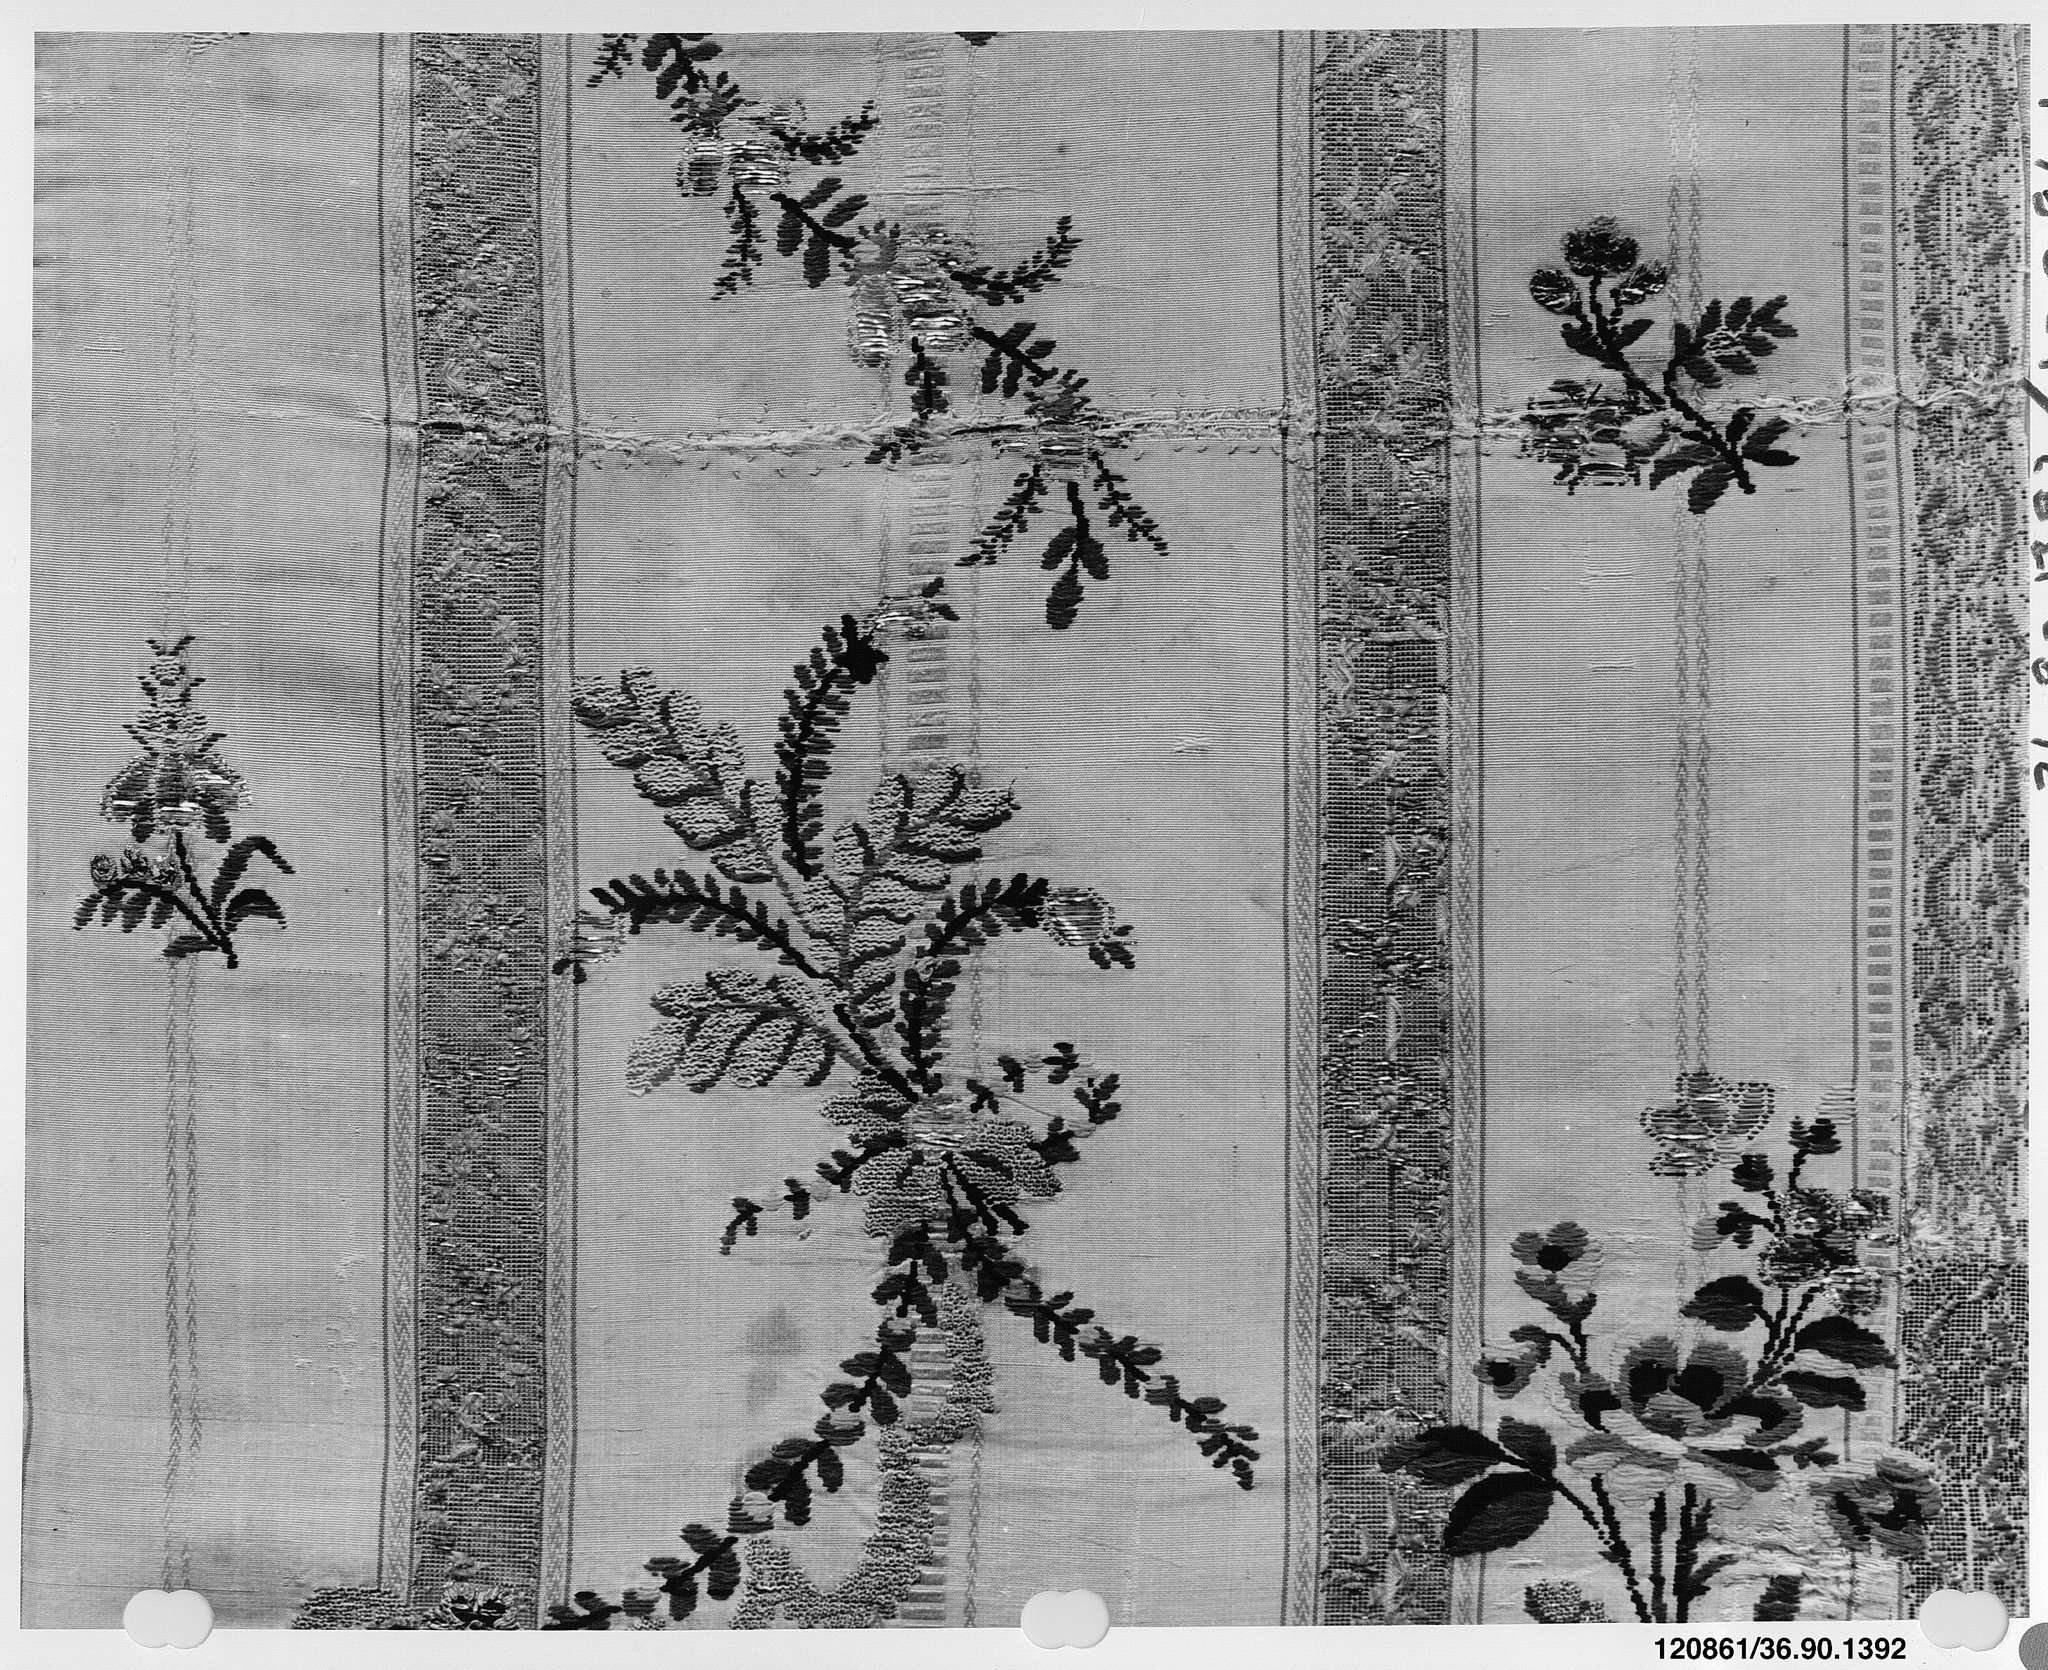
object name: piece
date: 1701-1800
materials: metal thread, silk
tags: flowers,leaves